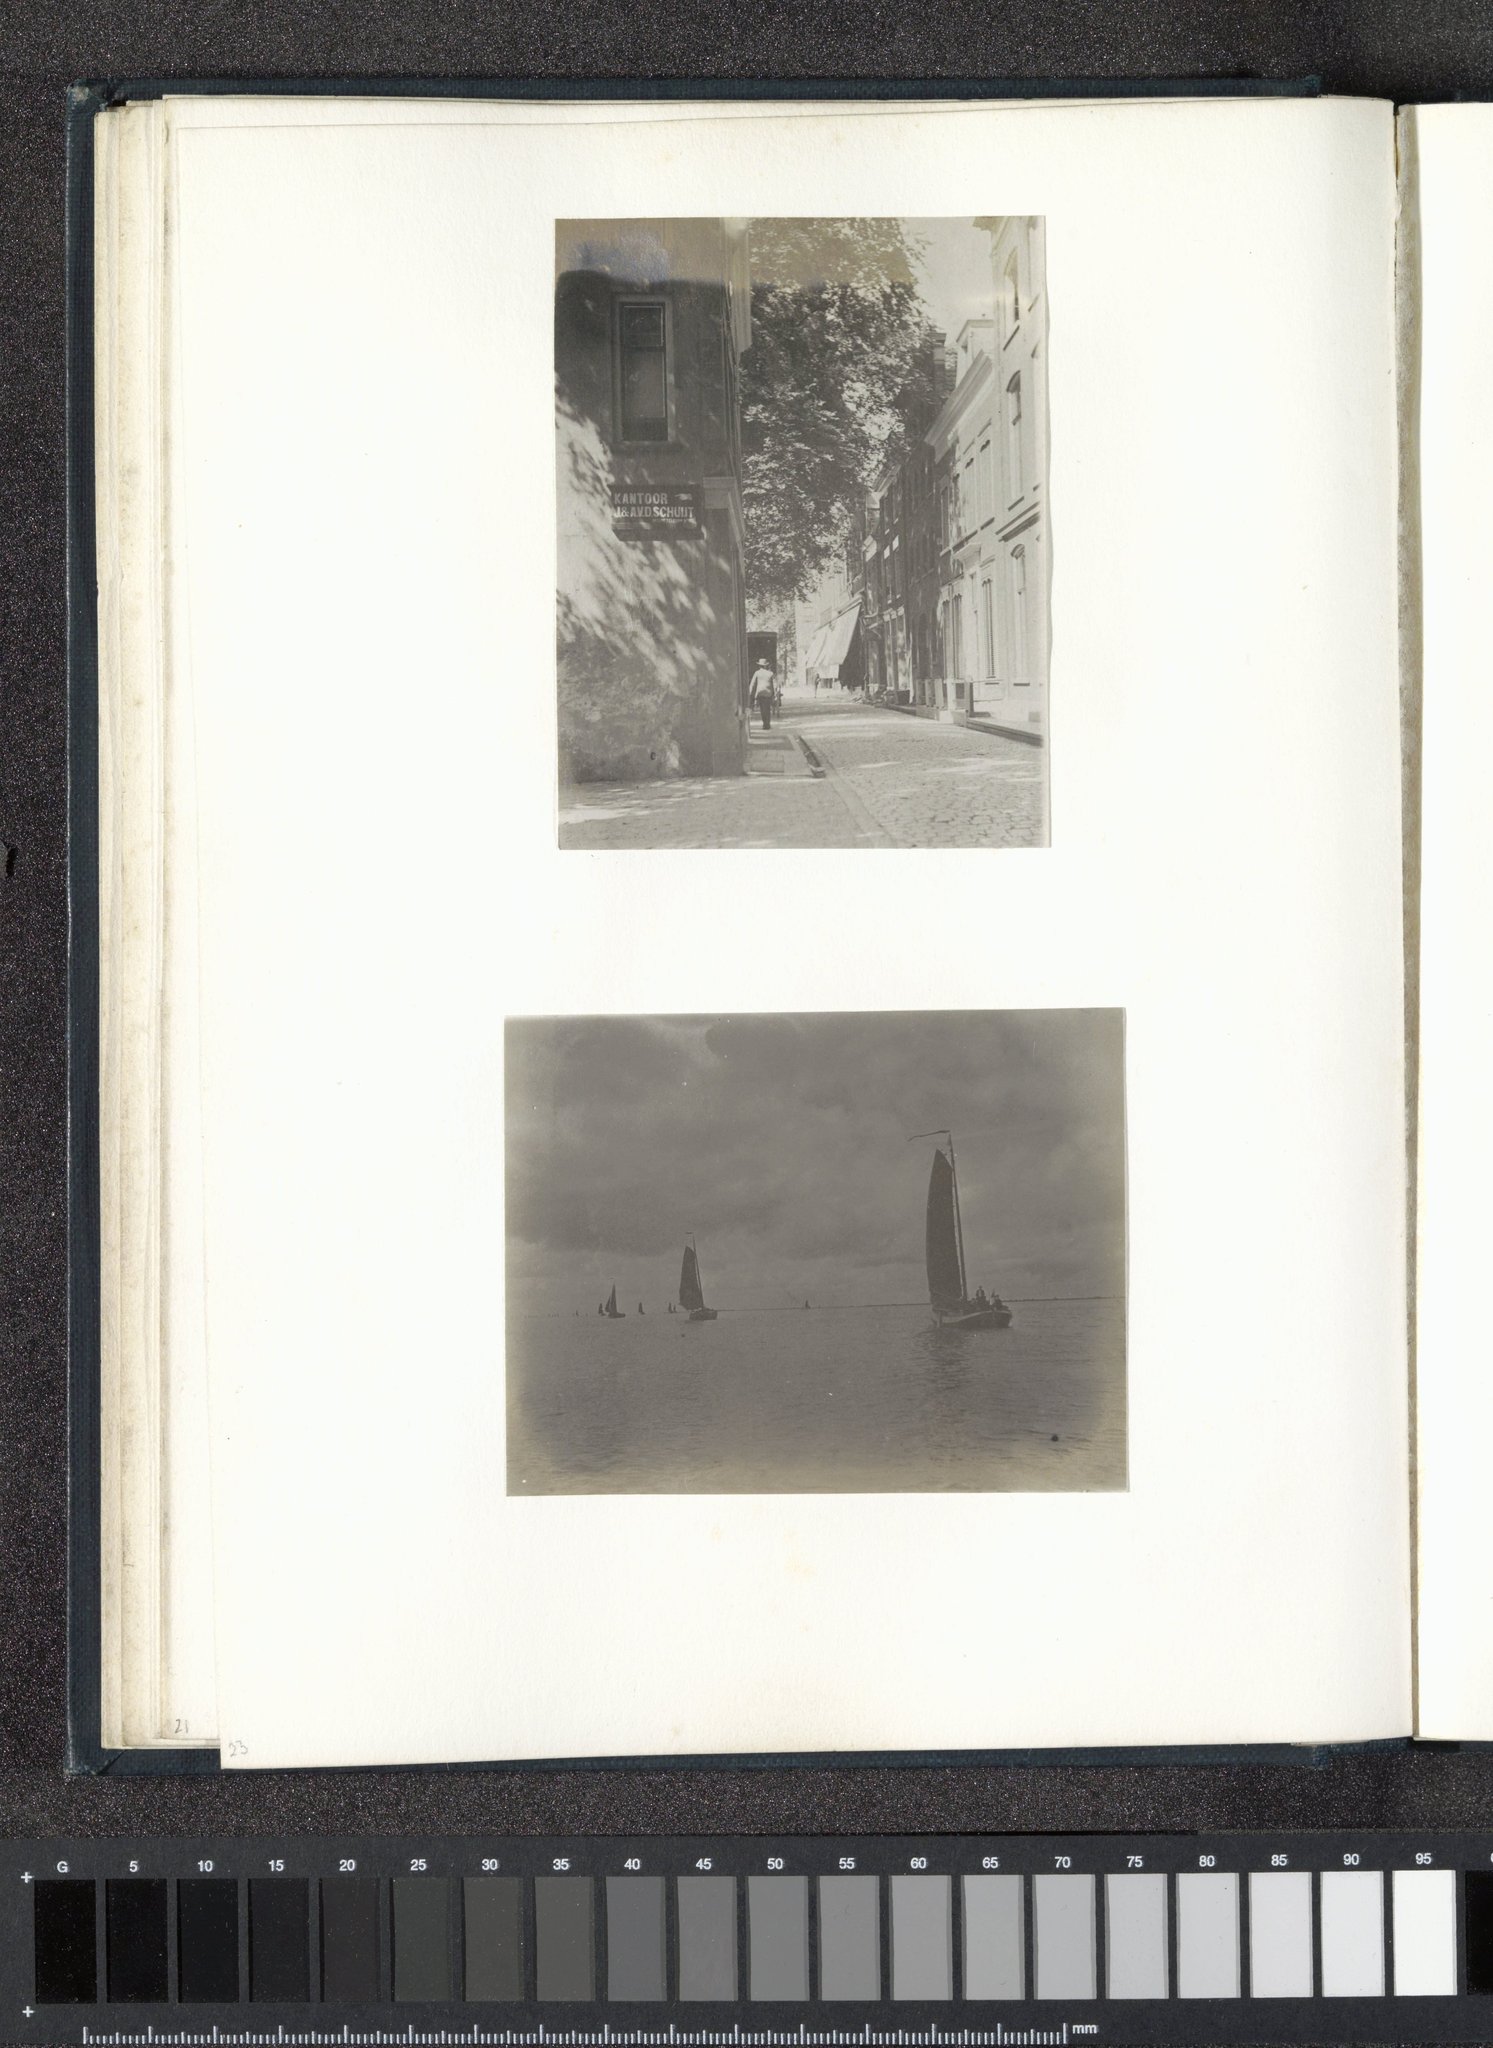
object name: photograph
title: Gezicht op de Appeldijk te Gorinchem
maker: george hidderley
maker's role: fotograaf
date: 1900-1910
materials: paper, photographic support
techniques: gelatin silver print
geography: volendam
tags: advertising, village street, the usual house or row of houses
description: Onderdeel van fotoalbum met opnames van Volendam, Dordrecht, Gorinchem en Woudrichem.